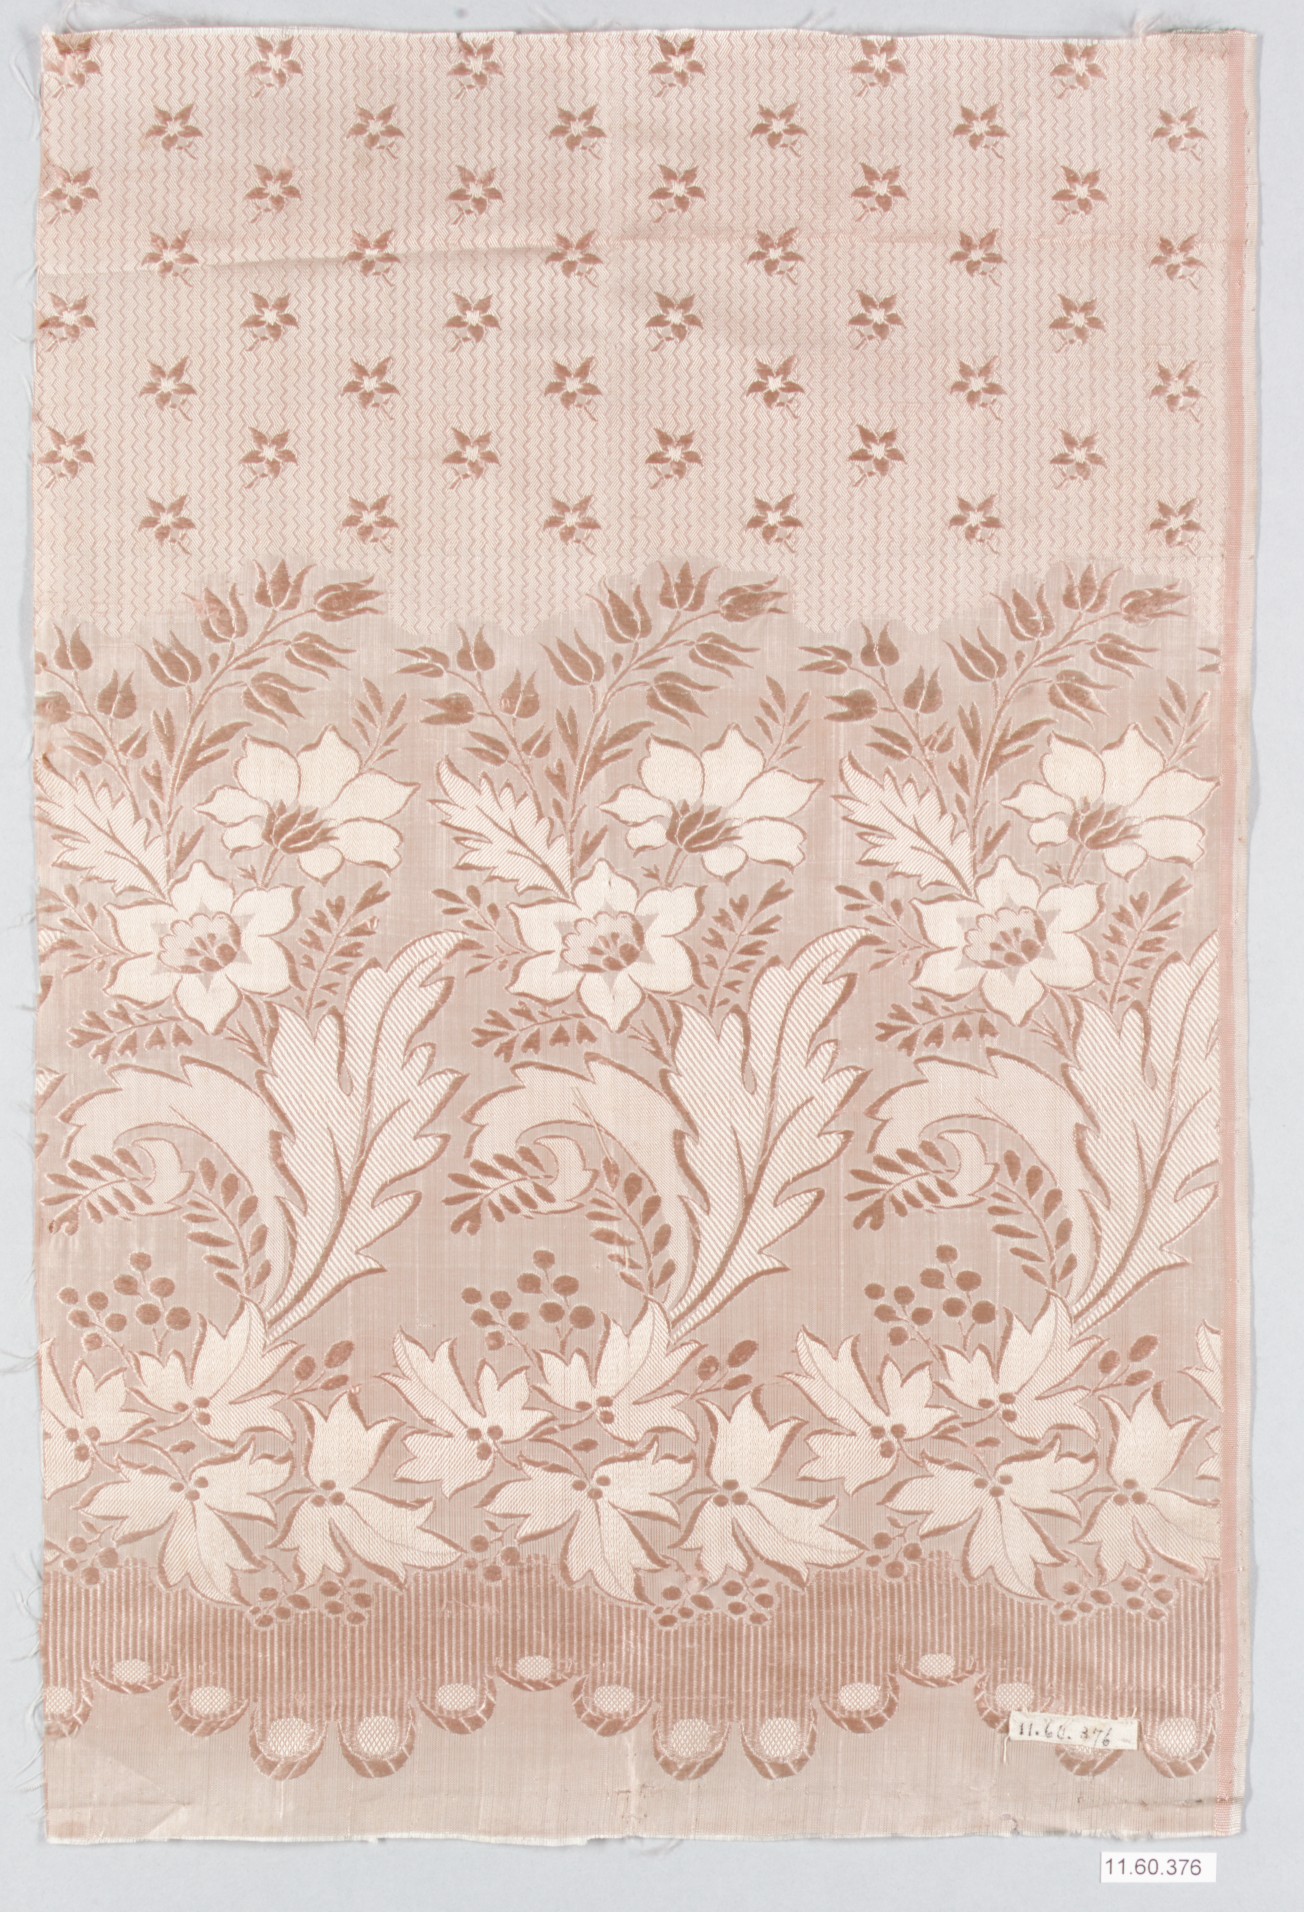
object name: fragment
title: Fragments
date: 1801-1900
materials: silk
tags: flowers,leaves